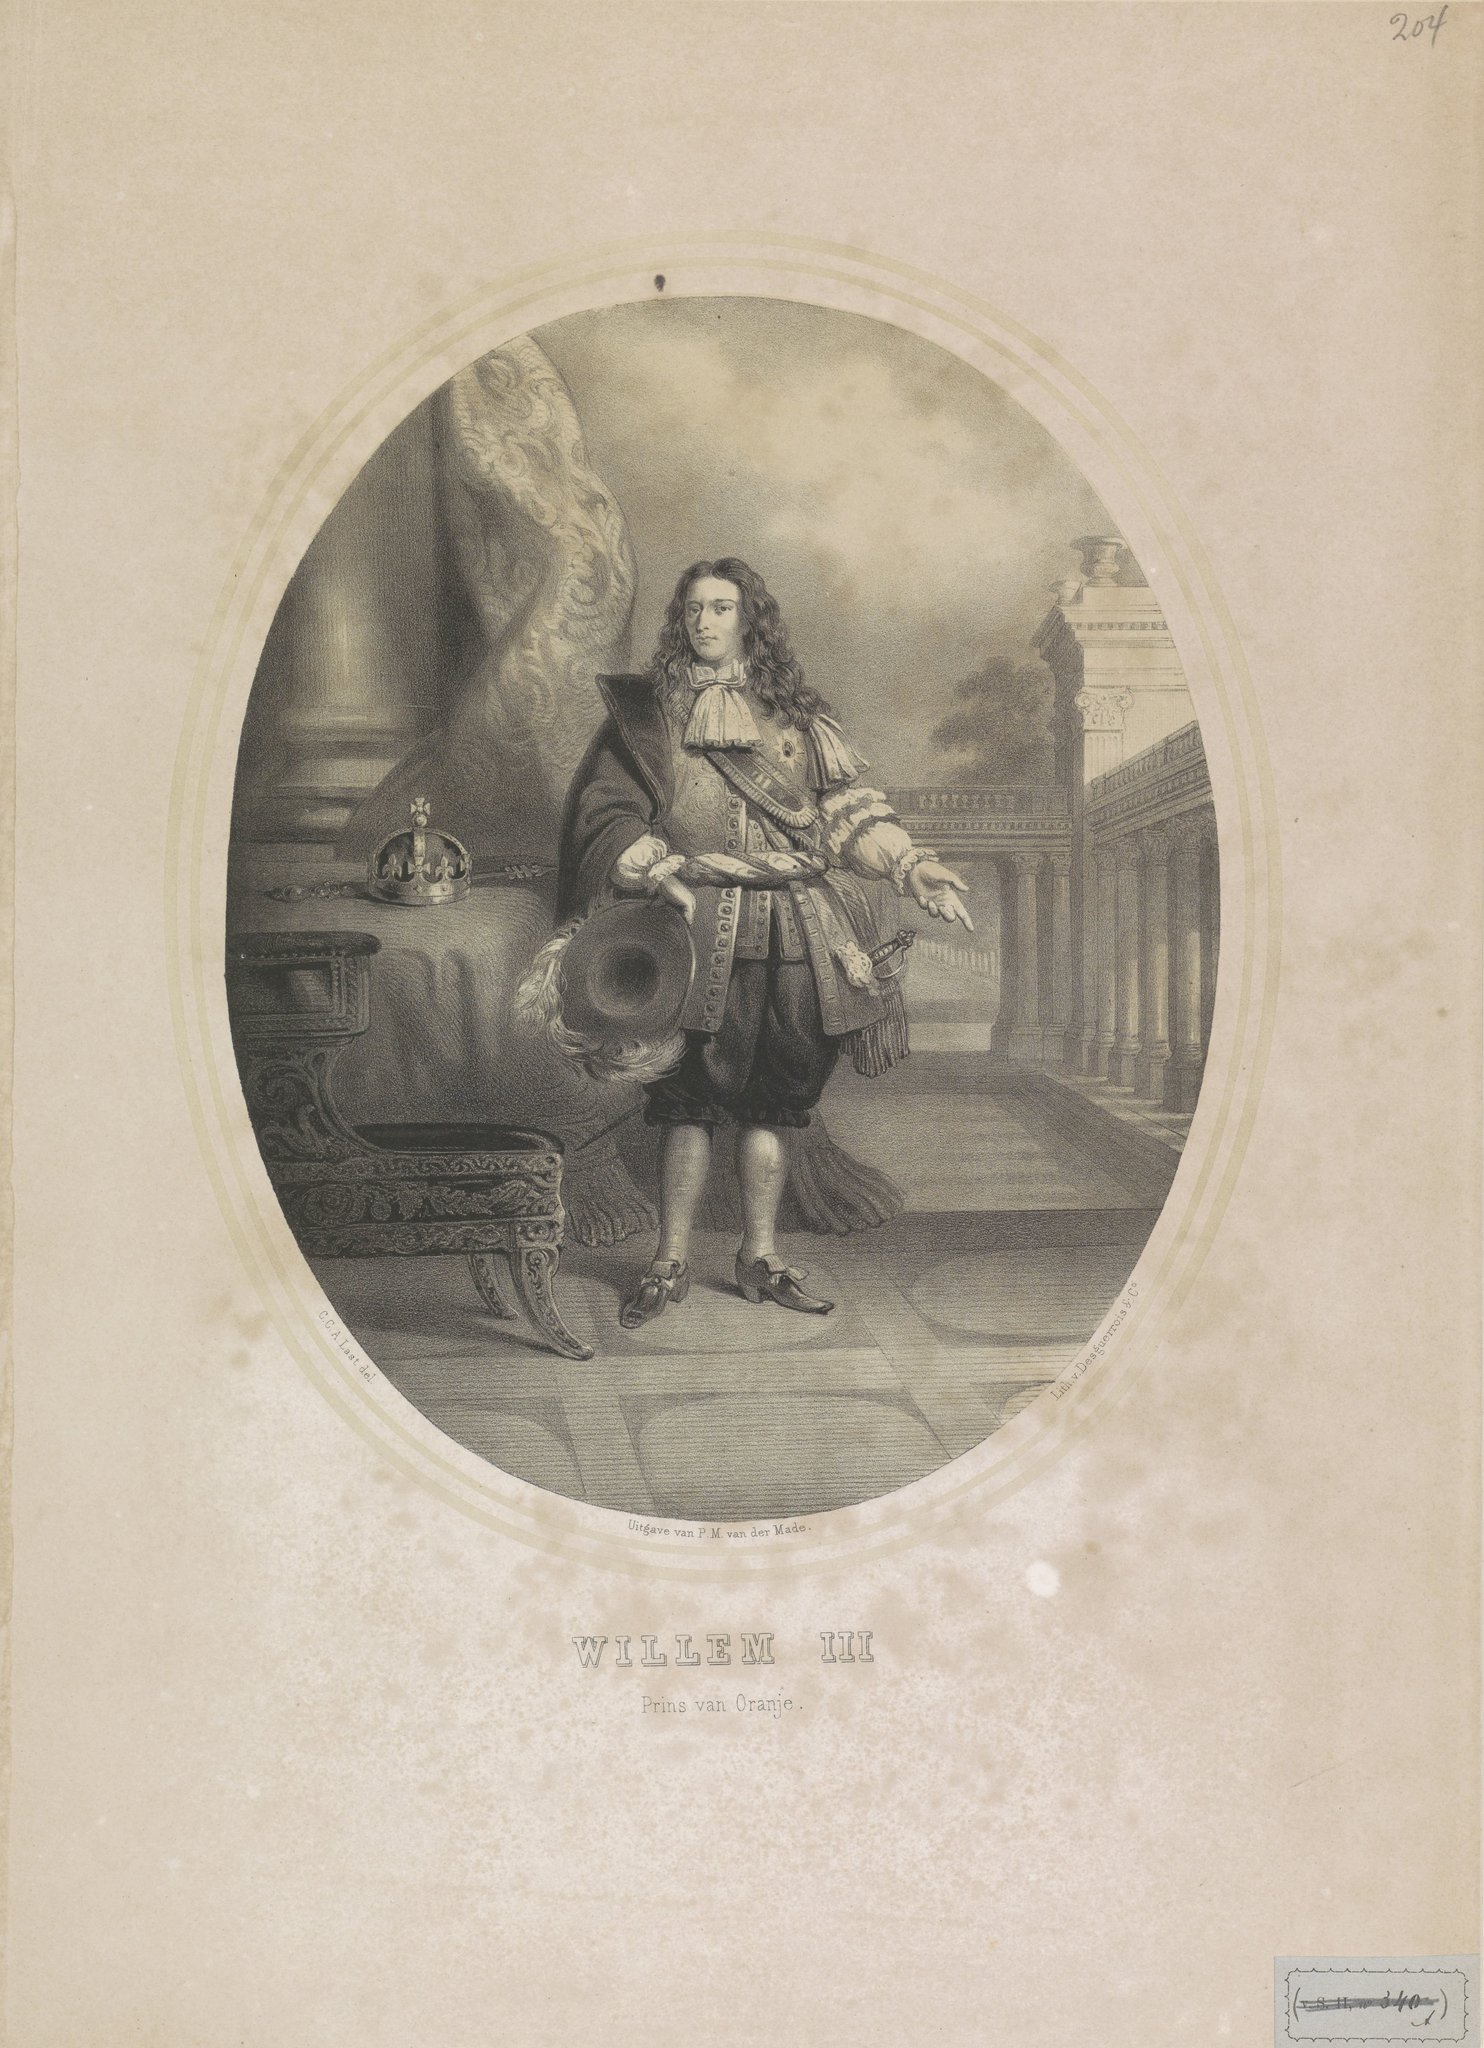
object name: print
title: Portret van Willem III, prins van Oranje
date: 1857-1873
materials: paper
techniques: tone lithography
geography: amsterdam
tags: the hague, william iii (prince of orange and king of england, scotland, and ireland)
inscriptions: collector's mark: Lugt 2228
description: De hier vermelde titel verwijst naar de hoogst verkregen titel van de geportretteerde, niet per se naar de titel die de geportretteerde op deze voorstelling draagt.